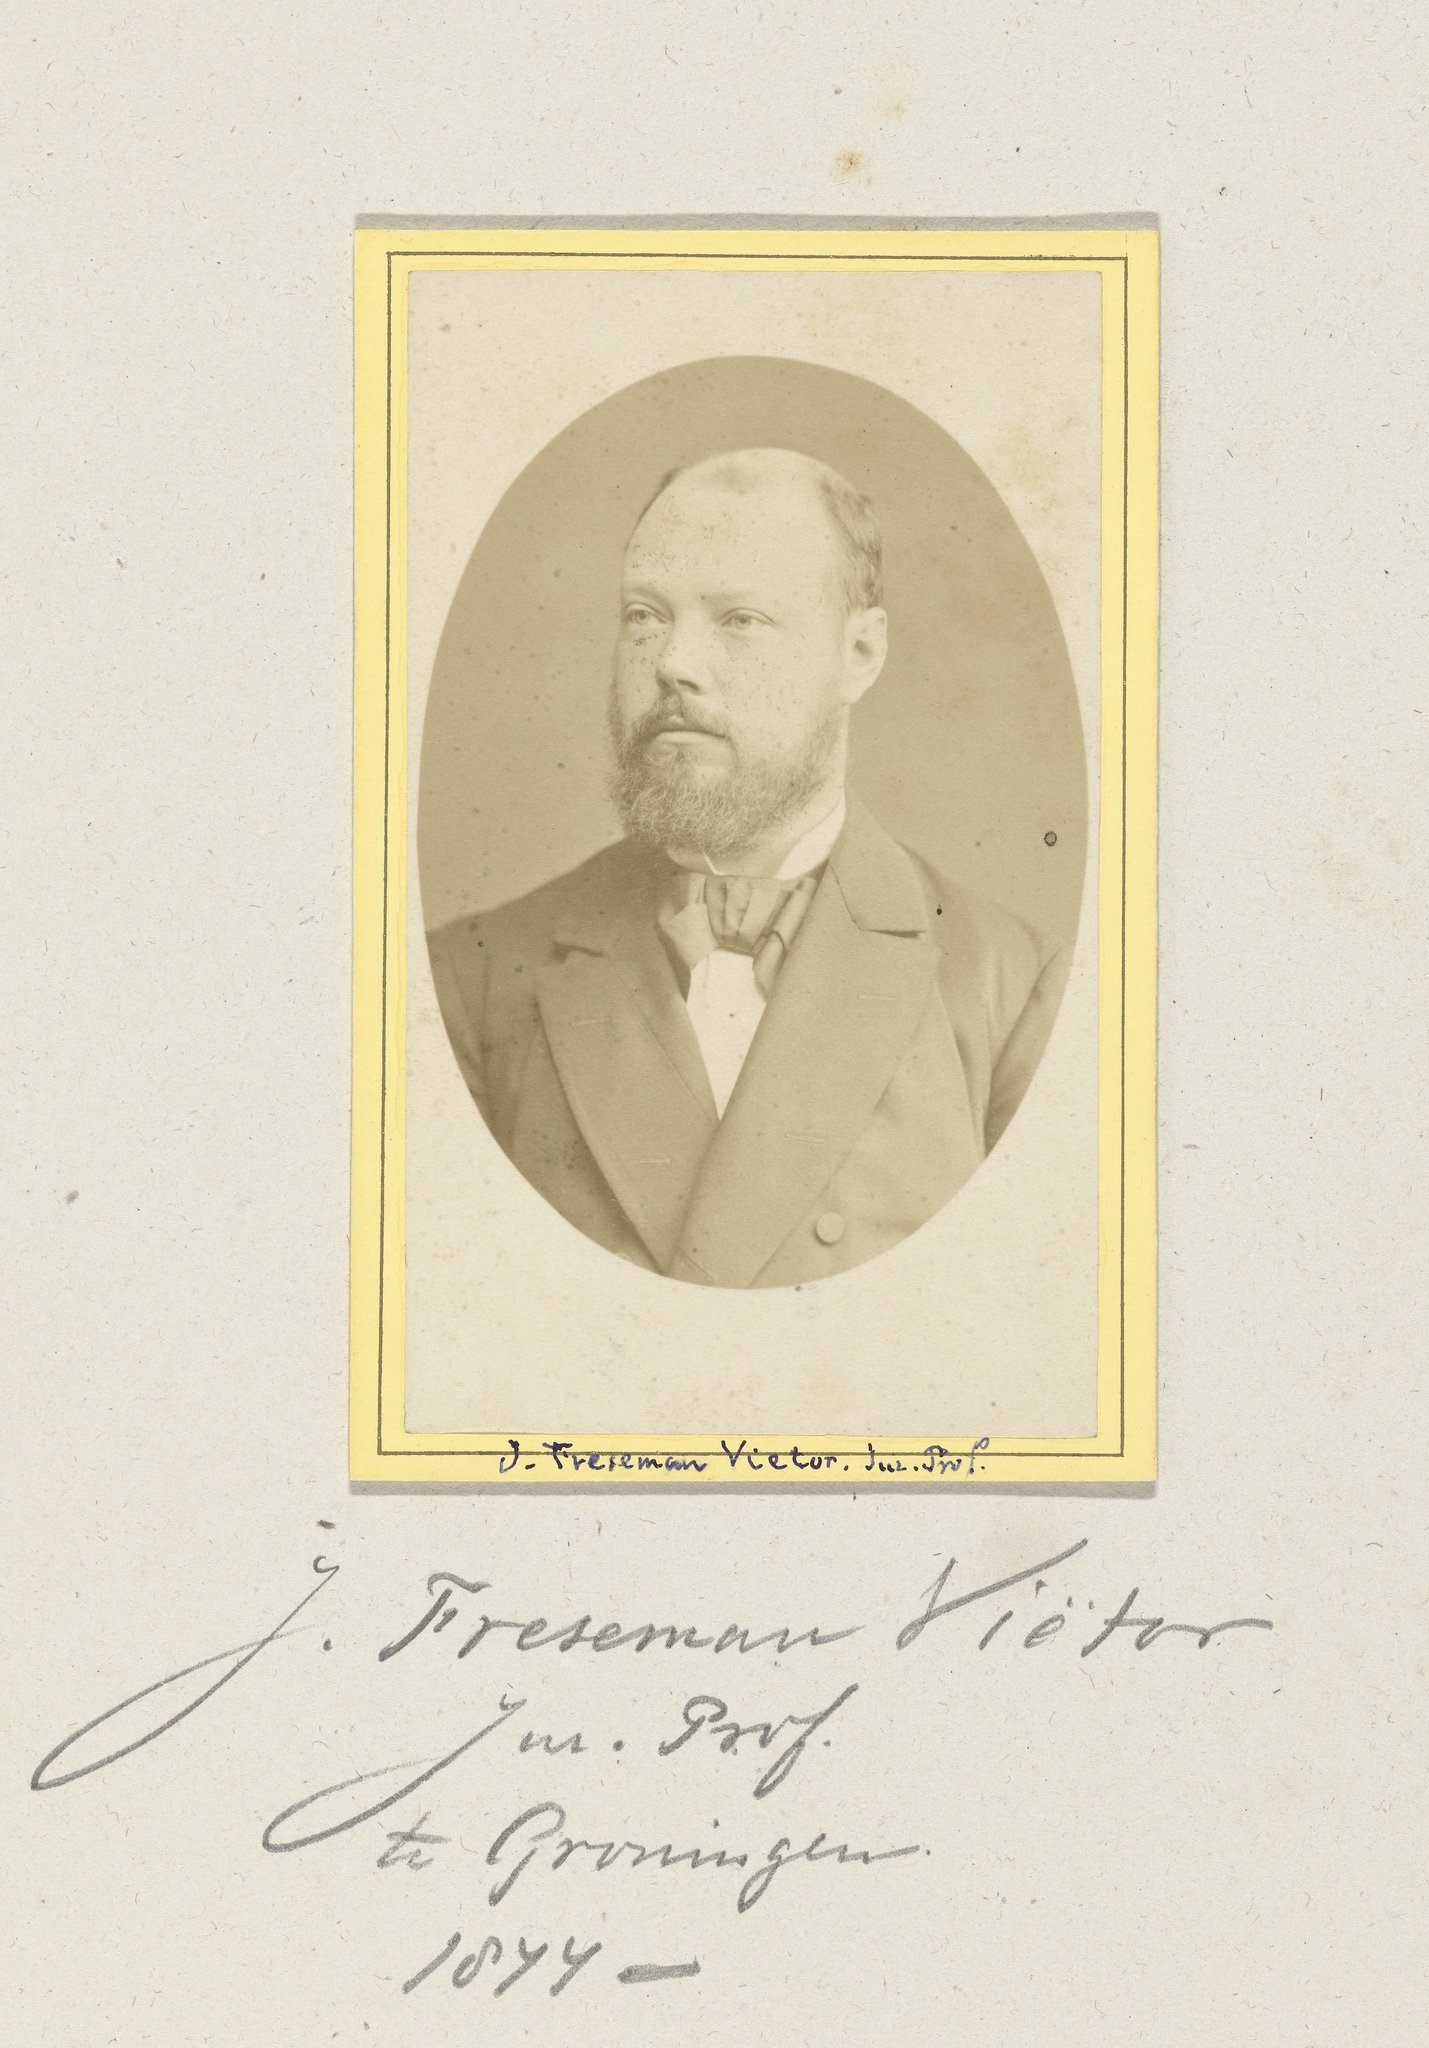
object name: carte de visite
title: Portret van professor J. Freseman Vietor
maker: Anonymous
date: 1860-1870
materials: paper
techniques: albumen print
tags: historical persons (portraits and scenes from the life)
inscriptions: name: ‘J. Freseman Vietor, jur. prof. te Groningen 1844 -’